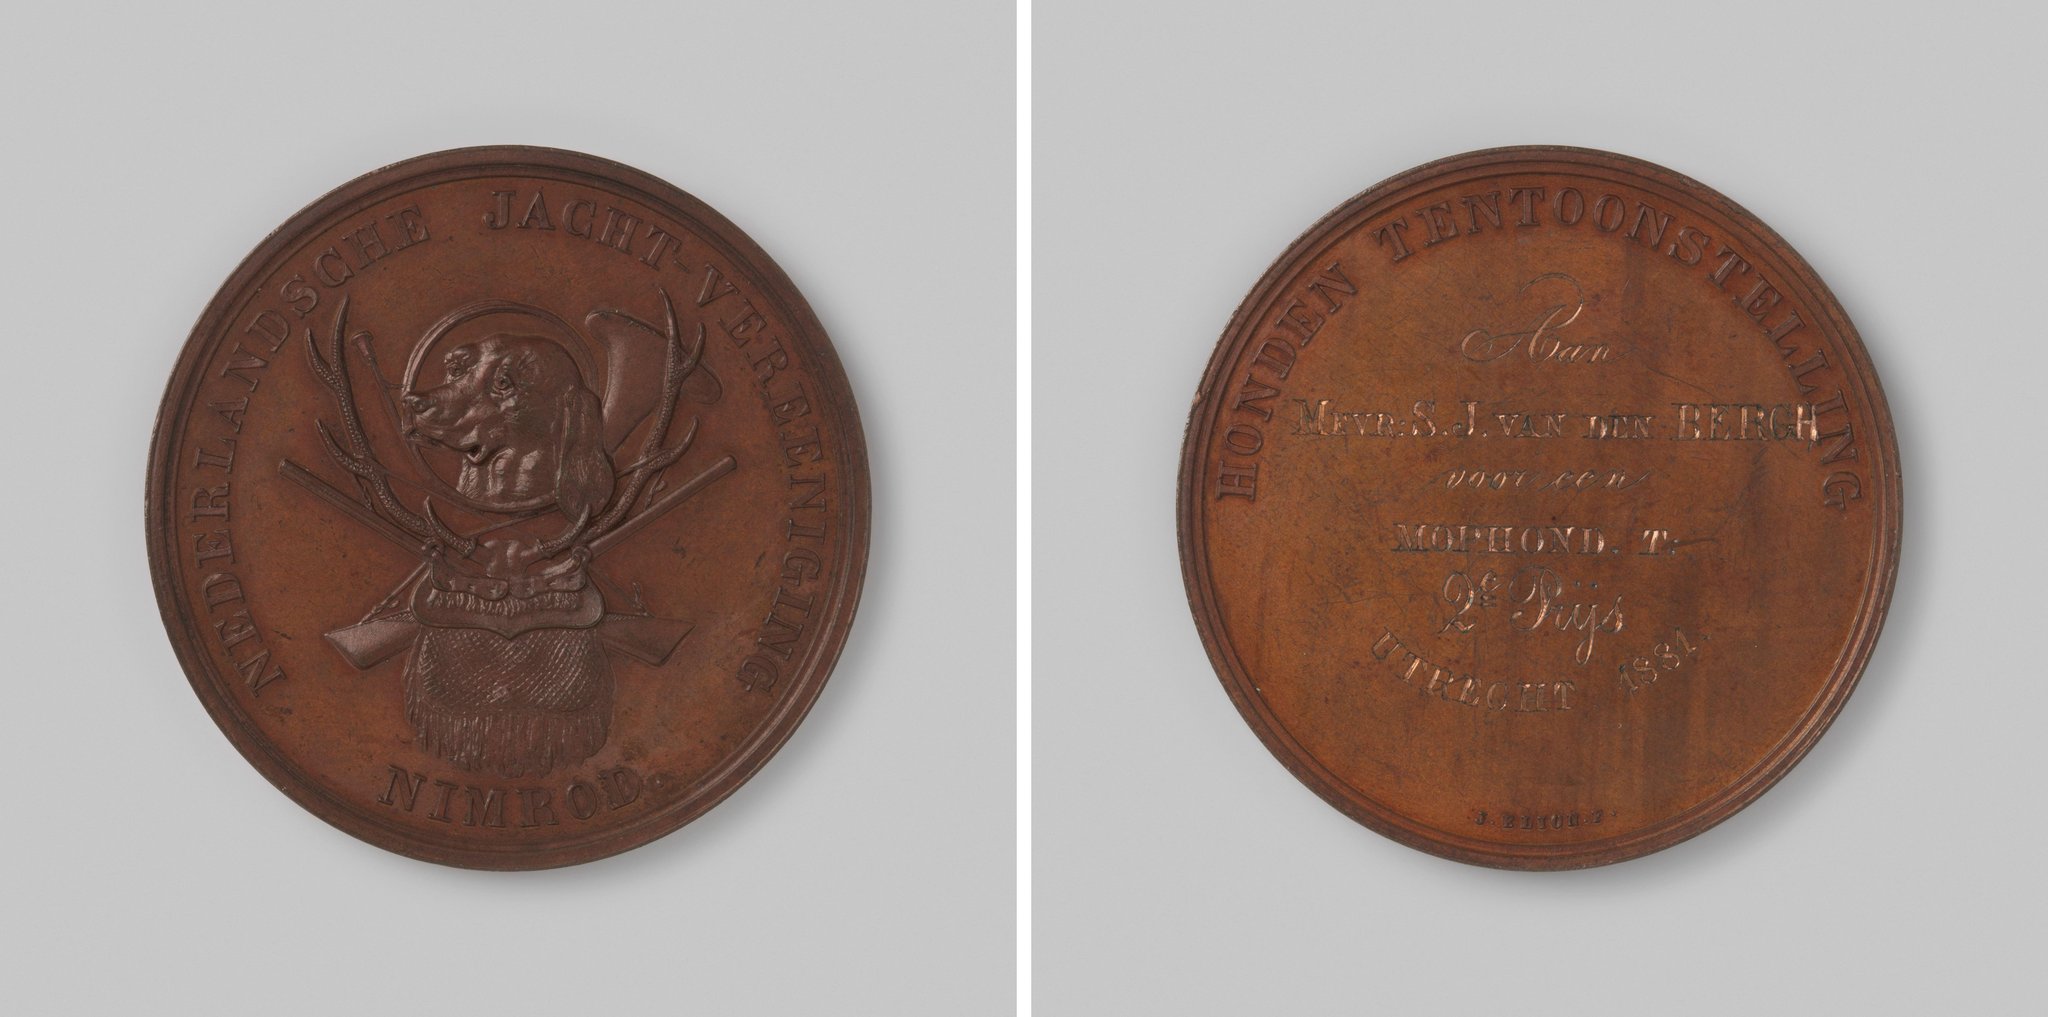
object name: history medal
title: Prijspenning van de Nederlandsche Jacht-Vereeniging Nimrod (1875) 1881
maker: jacob samuel cohen elion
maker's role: draughtsman, painter, print maker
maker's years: 1840-1893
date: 1875-1881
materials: bronze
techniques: engraving, striking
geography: amsterdam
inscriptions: inscription: ‘Aan / MEVR: S.J. VAN DEN BERGH / voor een / MOPHOND. T: / 2e Prijs / UTRECHT 1881.’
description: Bronzen penning, op de voorzijde een medaillon met hondenkop boven een weitas, gekruiste geweren en een hertengewei, met omschrift, op de keerzijde een inscriptieveld met randschrift bovenaan.